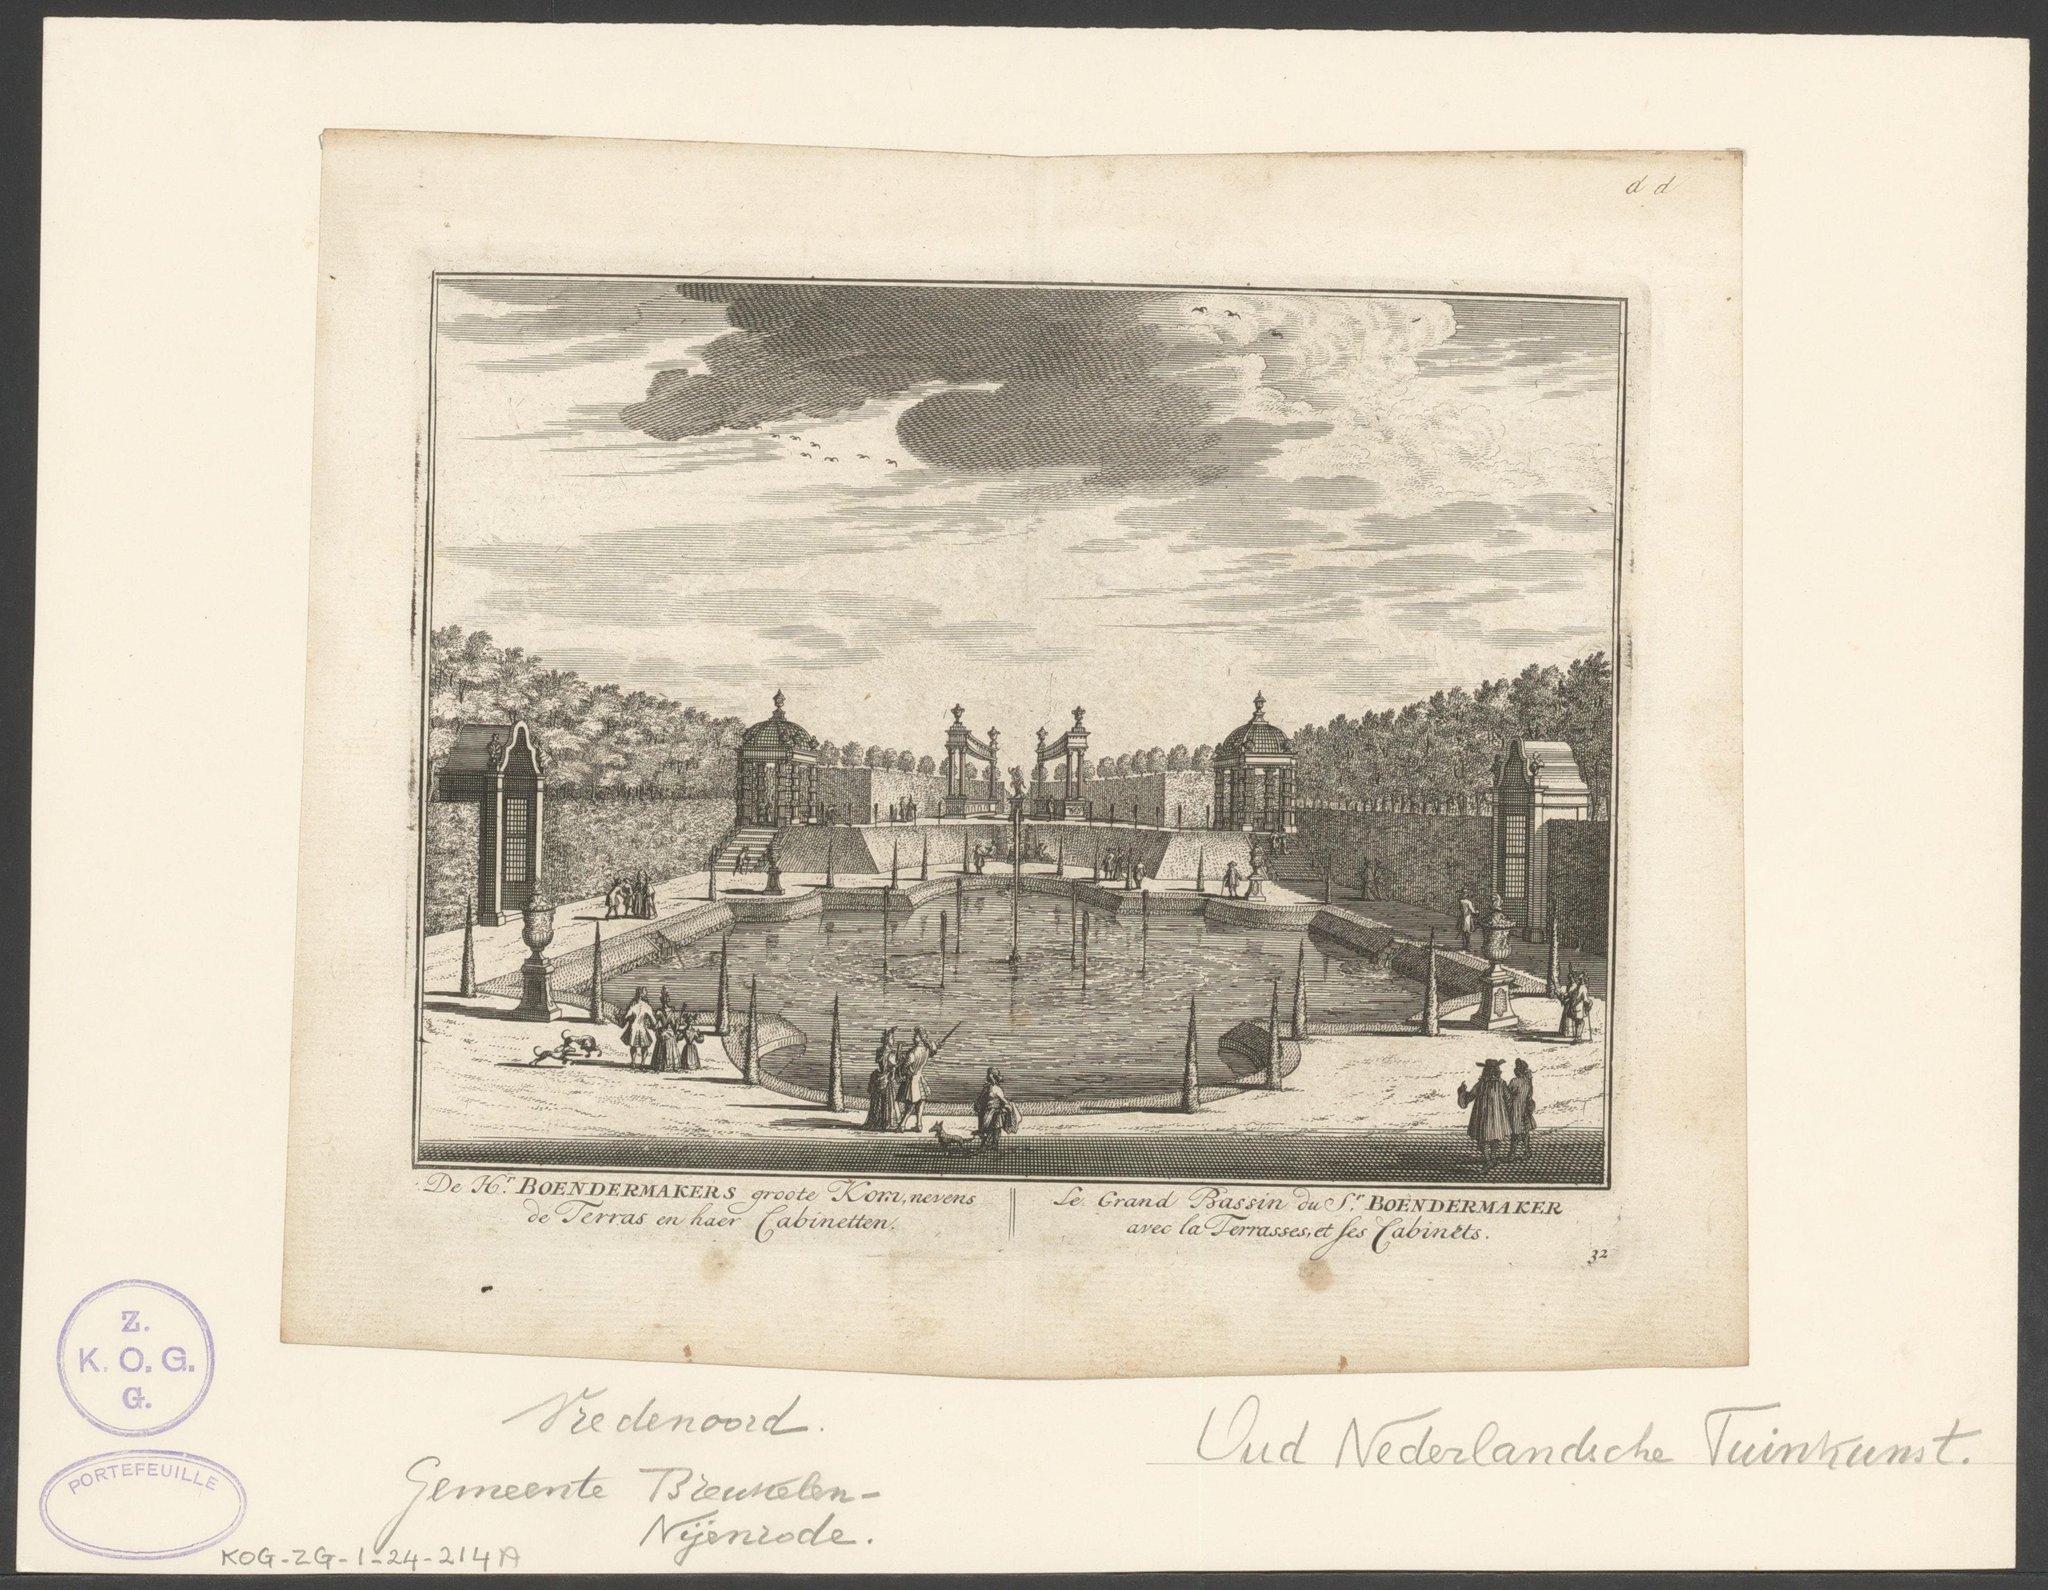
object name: print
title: Gezicht op de tuin van de buitenplaats van de heer Boendermaker bij Breukelen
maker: daniël stopendaal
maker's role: print maker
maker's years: 1672-1726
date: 1719-1790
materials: paper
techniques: engraving, etching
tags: country-house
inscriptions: stamp, collector's mark: Lugt 1641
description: Prent voor het eerst gebruikt in: Leth, Andries de. De zegepraalende Vecht, vertoonende verscheidene gesichten van lustplaatsen, heeren huysen en dorpen, beginnende van Uitrecht en met Muyden besluytende (...). Amsterdam: Weduwe Nicolaus Visscher, 1719. Prent mogelijk uit: Brouërius van Nidek, Matthaeus. De Vechtstroom, van Utrecht tot Muiden (...). Amsterdam: H. Gartman, W. Vermandel en J.W. Smit, 1790.